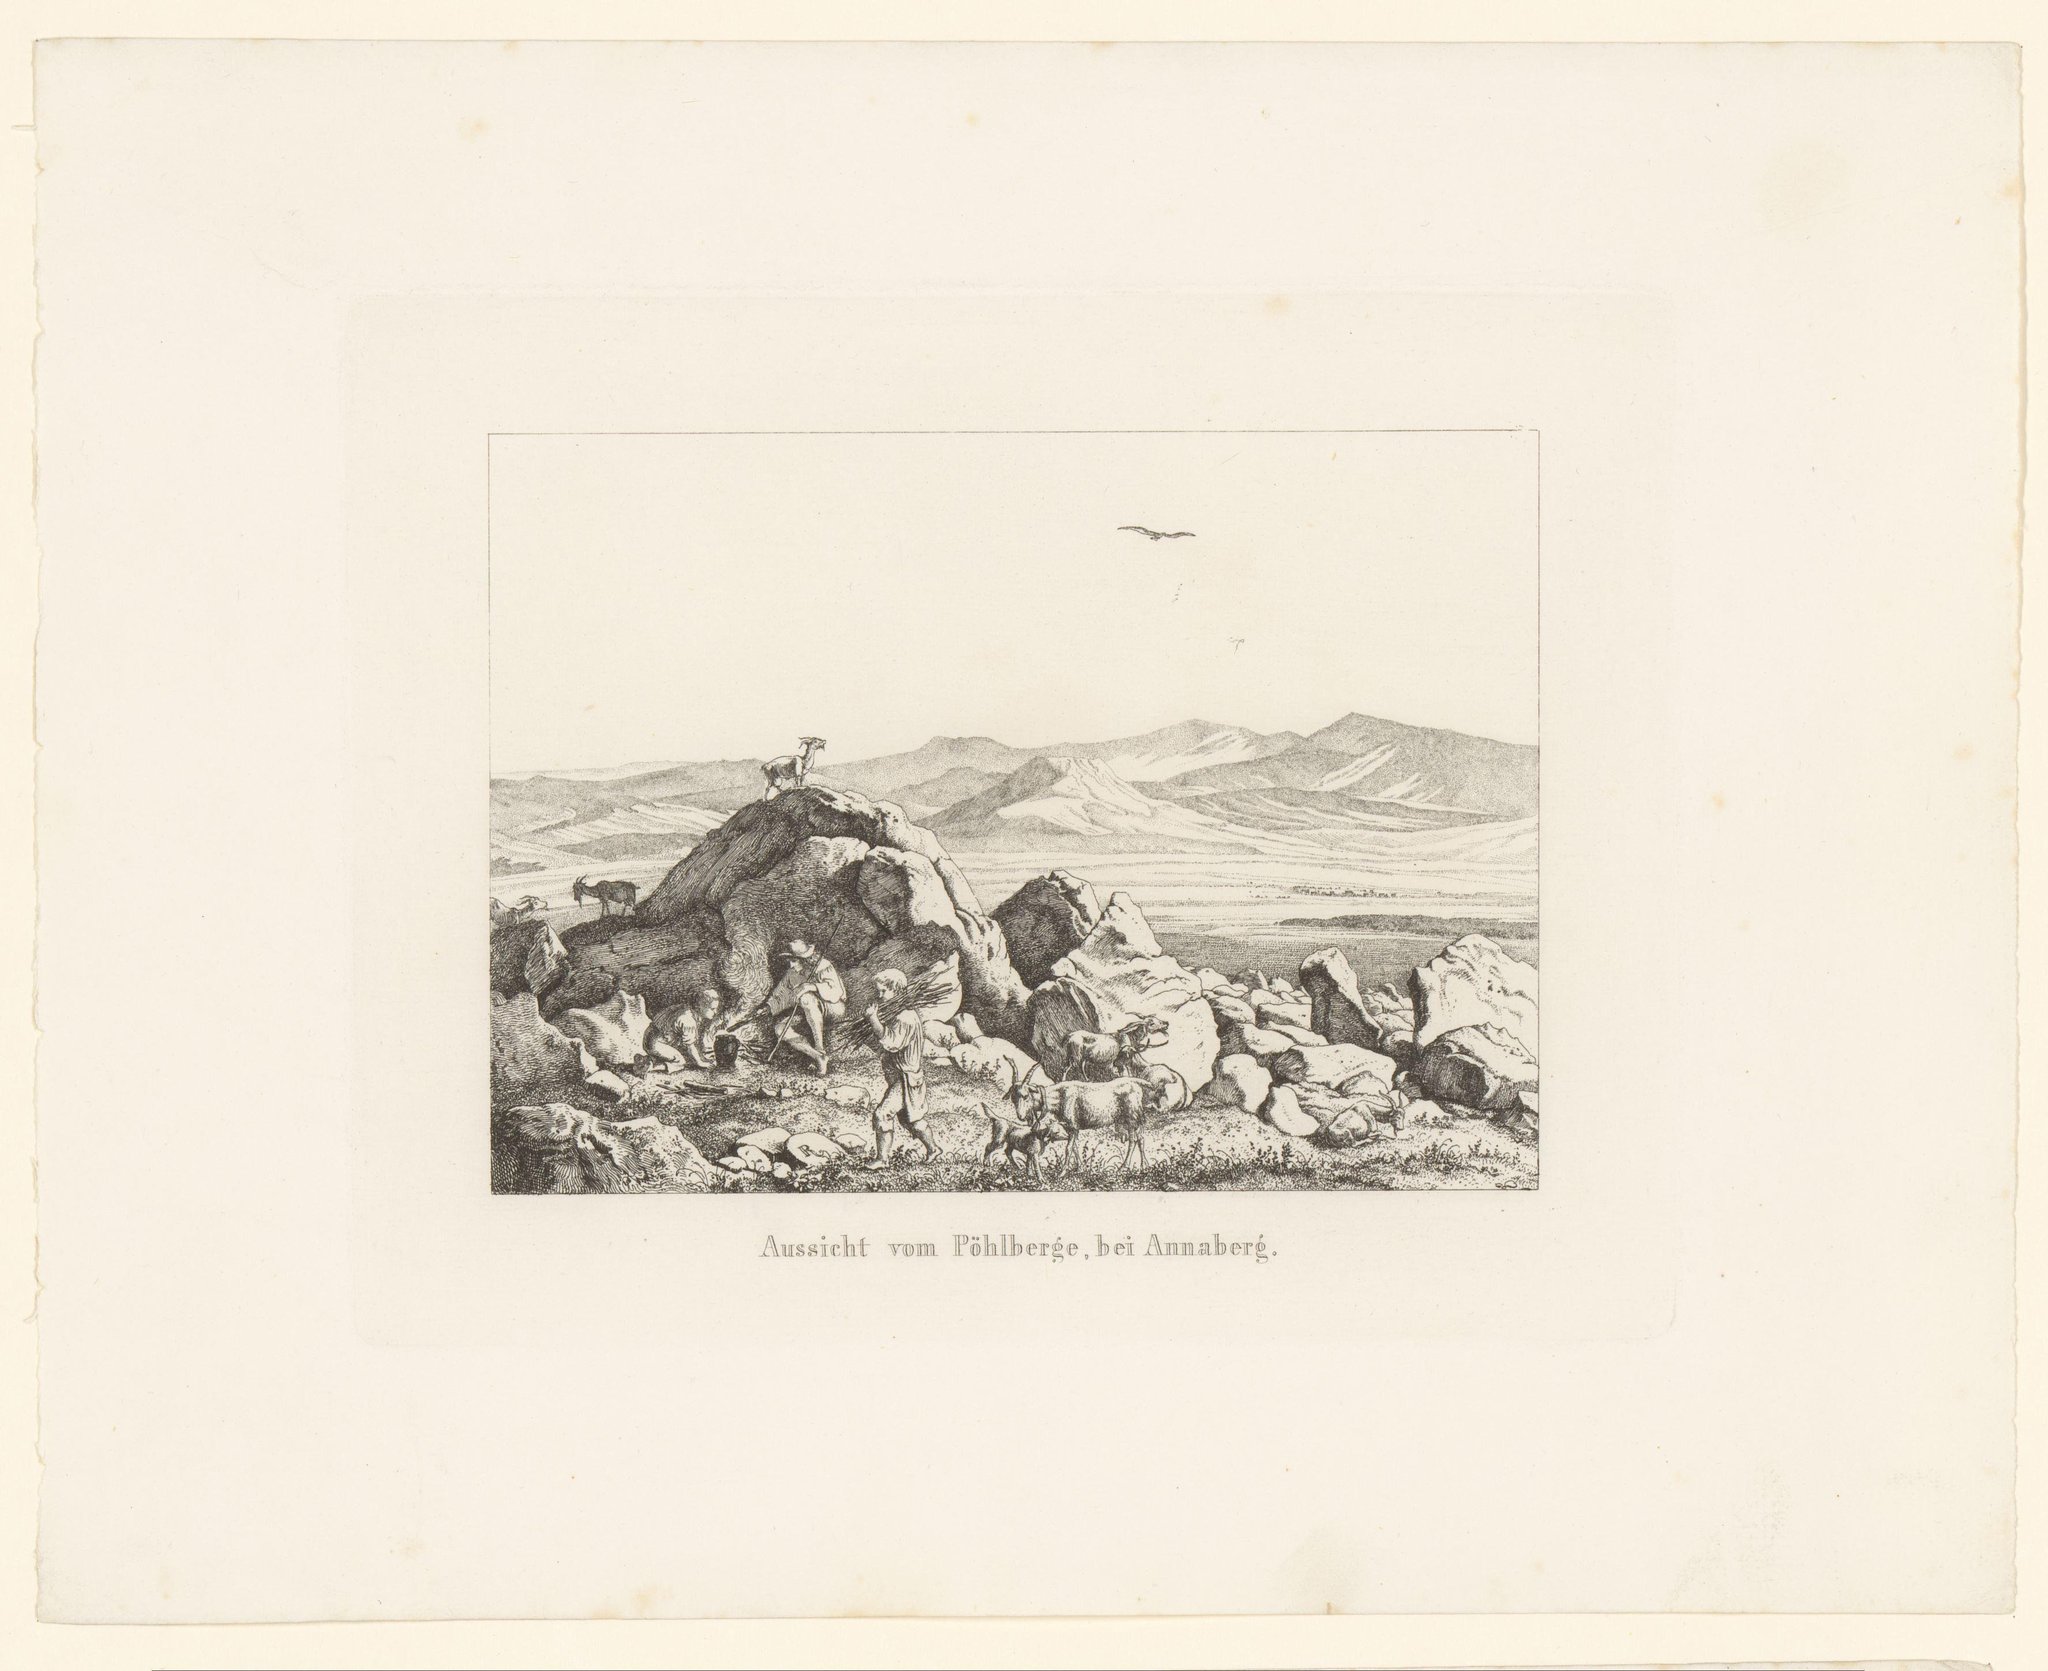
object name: print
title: Monumenten van Sachsen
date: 1828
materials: paper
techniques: etching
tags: landscapes, mountain-range, snow peaks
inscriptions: collector's mark: Lugt 2228